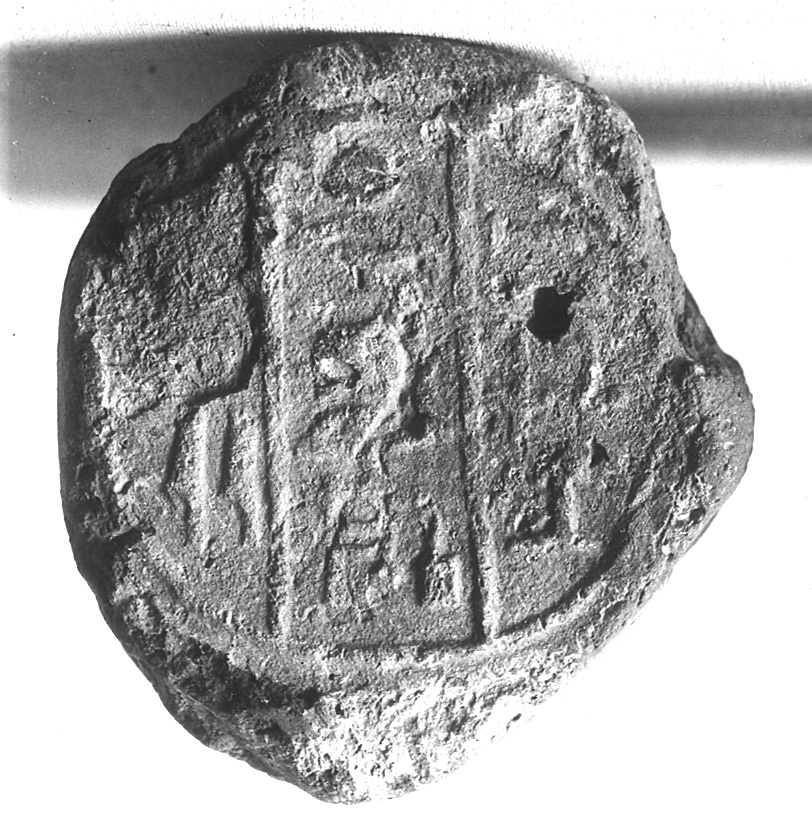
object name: cone, circular impression, aanen, scribe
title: Funerary Cone of the Scribe Aanen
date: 1550-1352 BCE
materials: pottery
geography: egypt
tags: hieroglyphs